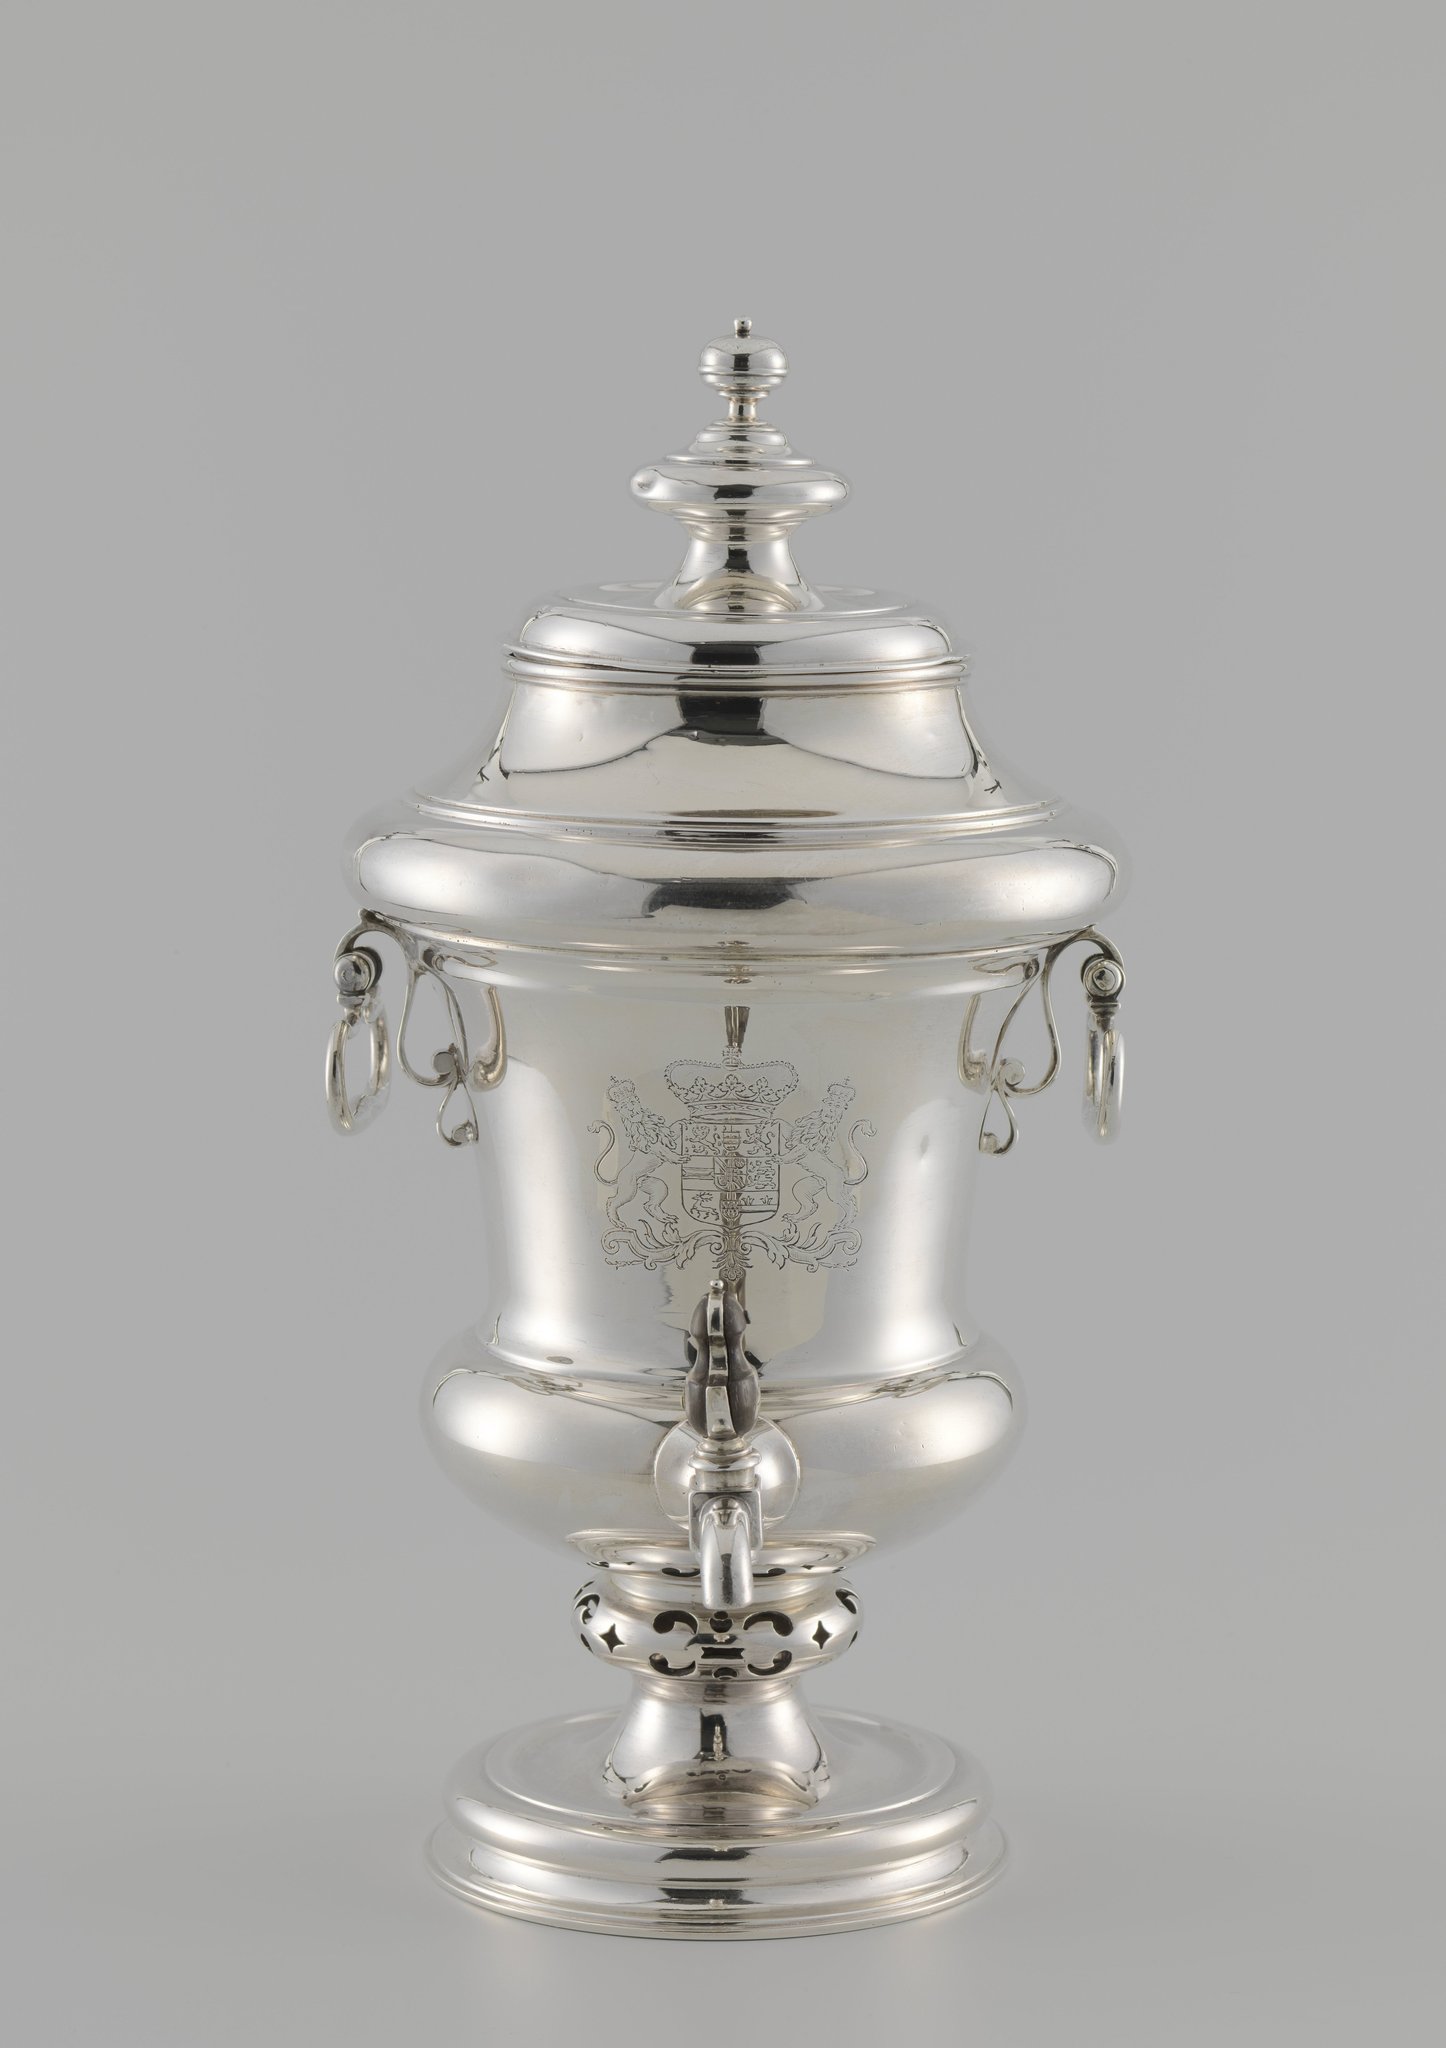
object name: ewer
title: Kraantjeskan in de vorm van een tuinvaas met één kraan en twee hengsels. Met het gegraveerde wapen van Stadhouder Willem IV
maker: jesaias engouw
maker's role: silversmith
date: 1720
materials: wood, silver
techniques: casting, engraving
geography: the hague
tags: the hague, willem iv (prins van oranje-nassau)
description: Coffee urn engraved with the arms of Prince William IV of Orange. Silver. The Hague, 1720, by Jesaias Engouw.